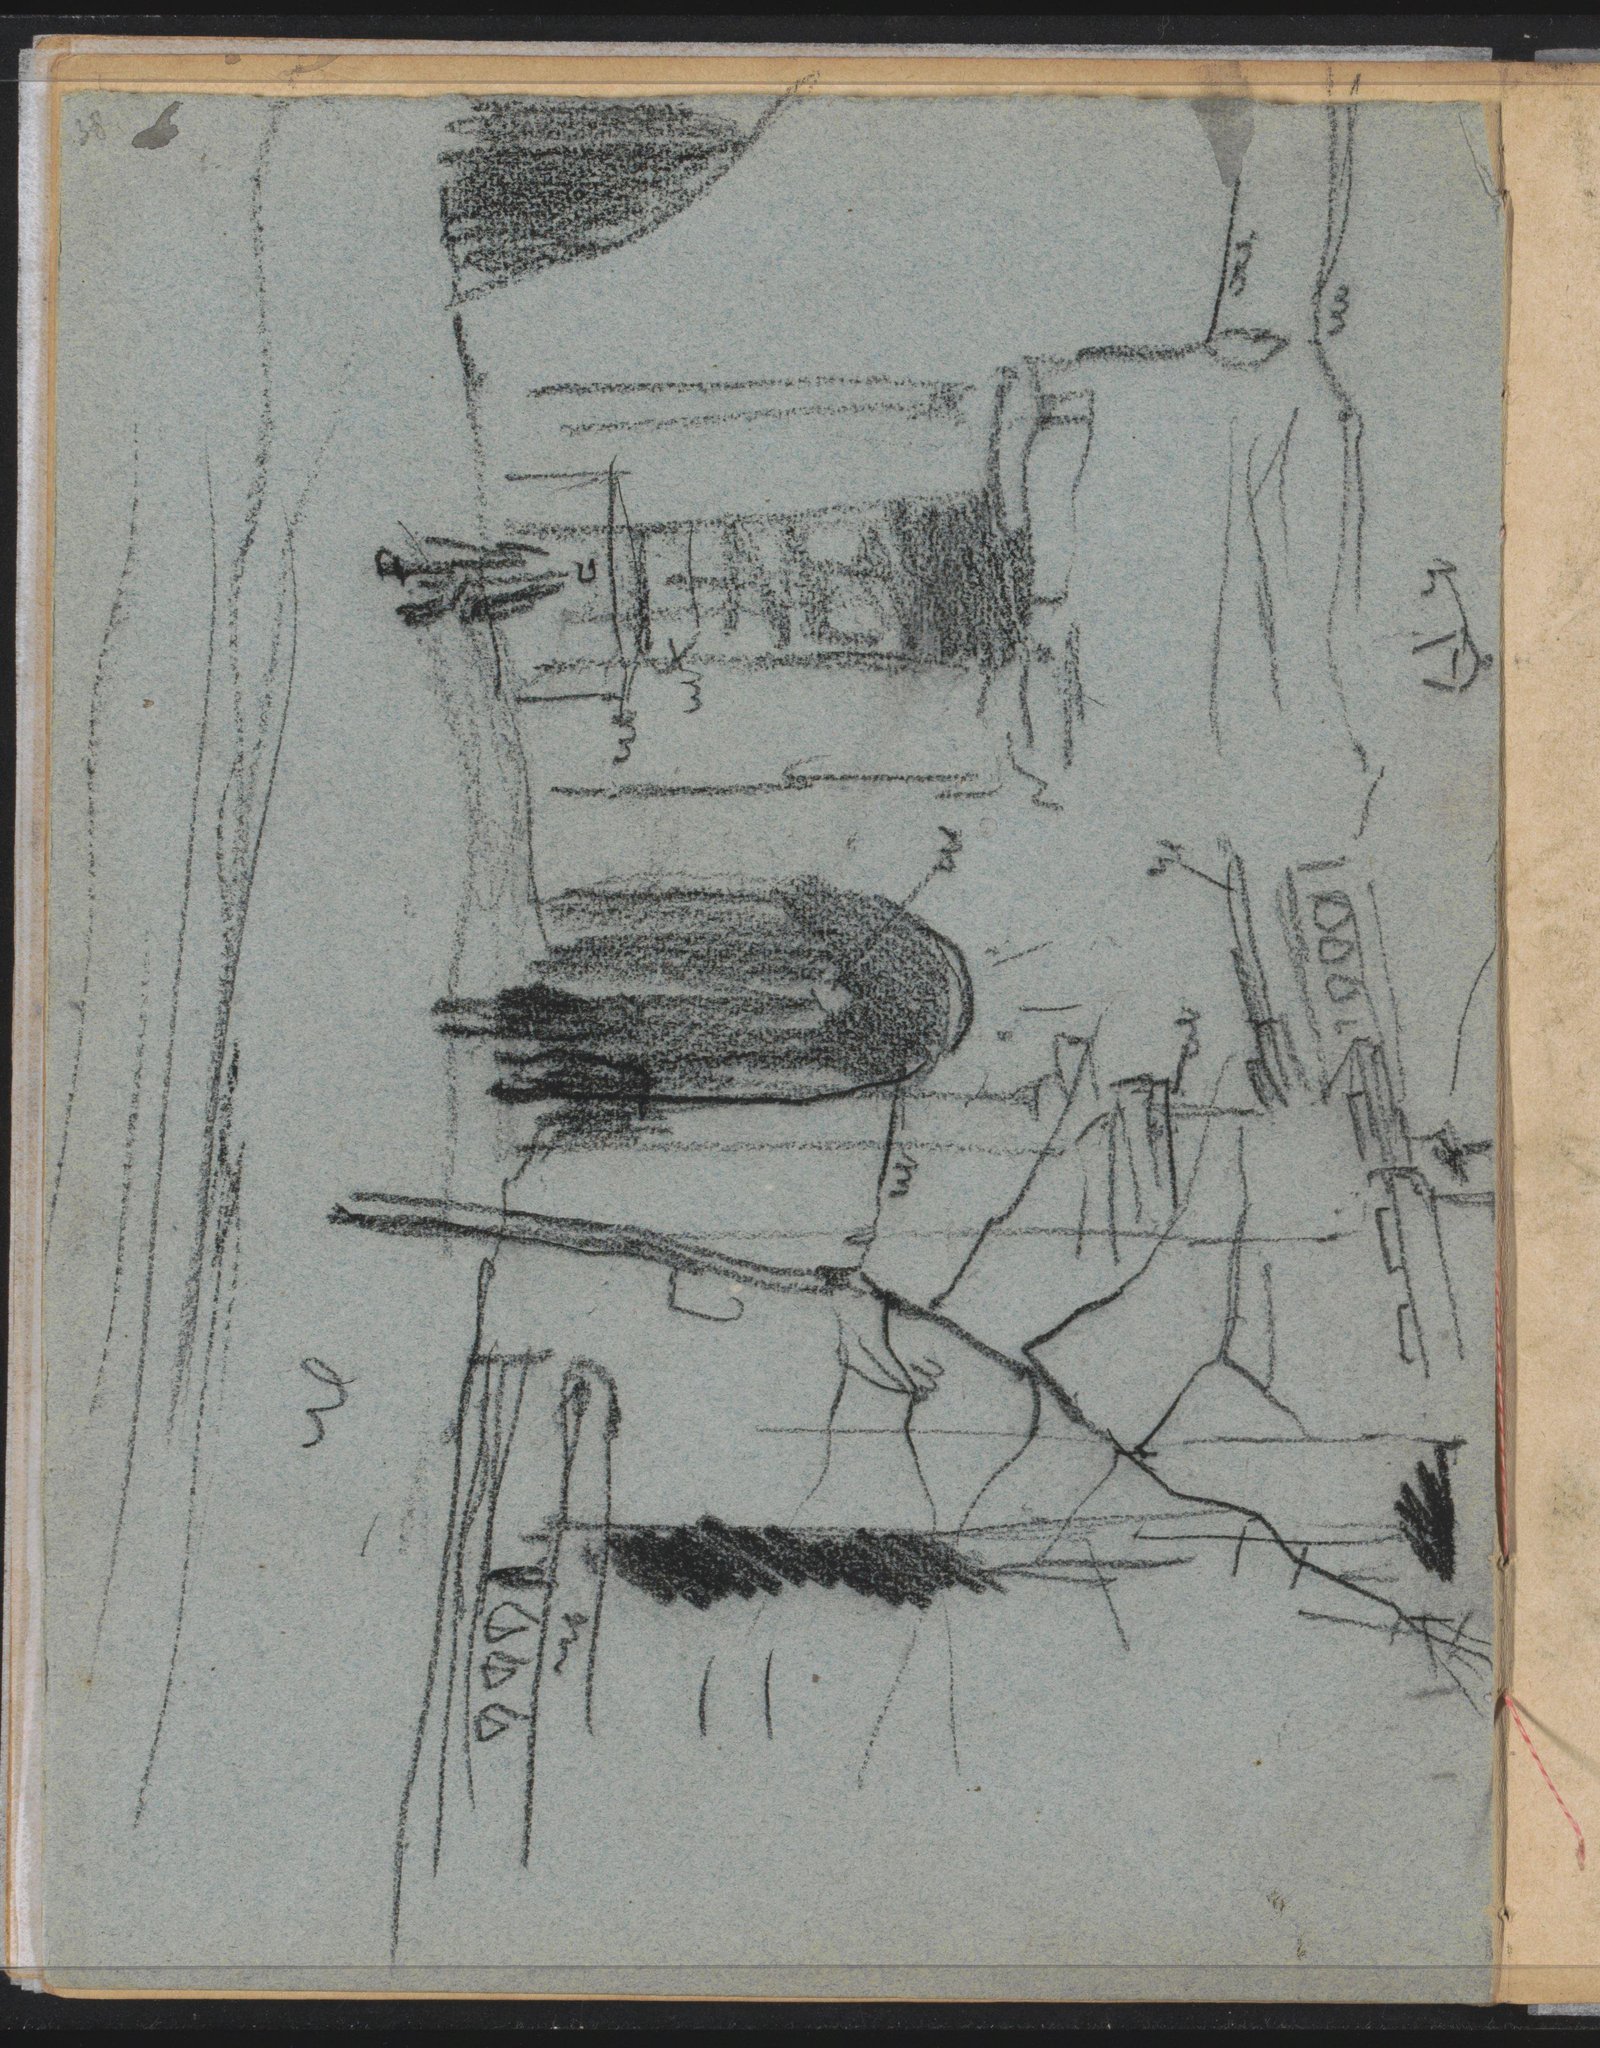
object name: sketchbook leaf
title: Gezicht op Somerset House en Waterloo Bridge te Londen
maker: willem witsen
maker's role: draughtsman, painter, print maker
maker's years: 1860-1923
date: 1888-1890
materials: chalk, paper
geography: london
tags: bridge in city across river, canal, etc. (+ city(-scape) with figures, staffage), civic architecture; edifices; dwellings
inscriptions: kleurnotitie, handgeschreven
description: Voorstudie voor de ets 'Wachtende rijtuigen bij Waterloo Bridge, Londen', 1890.